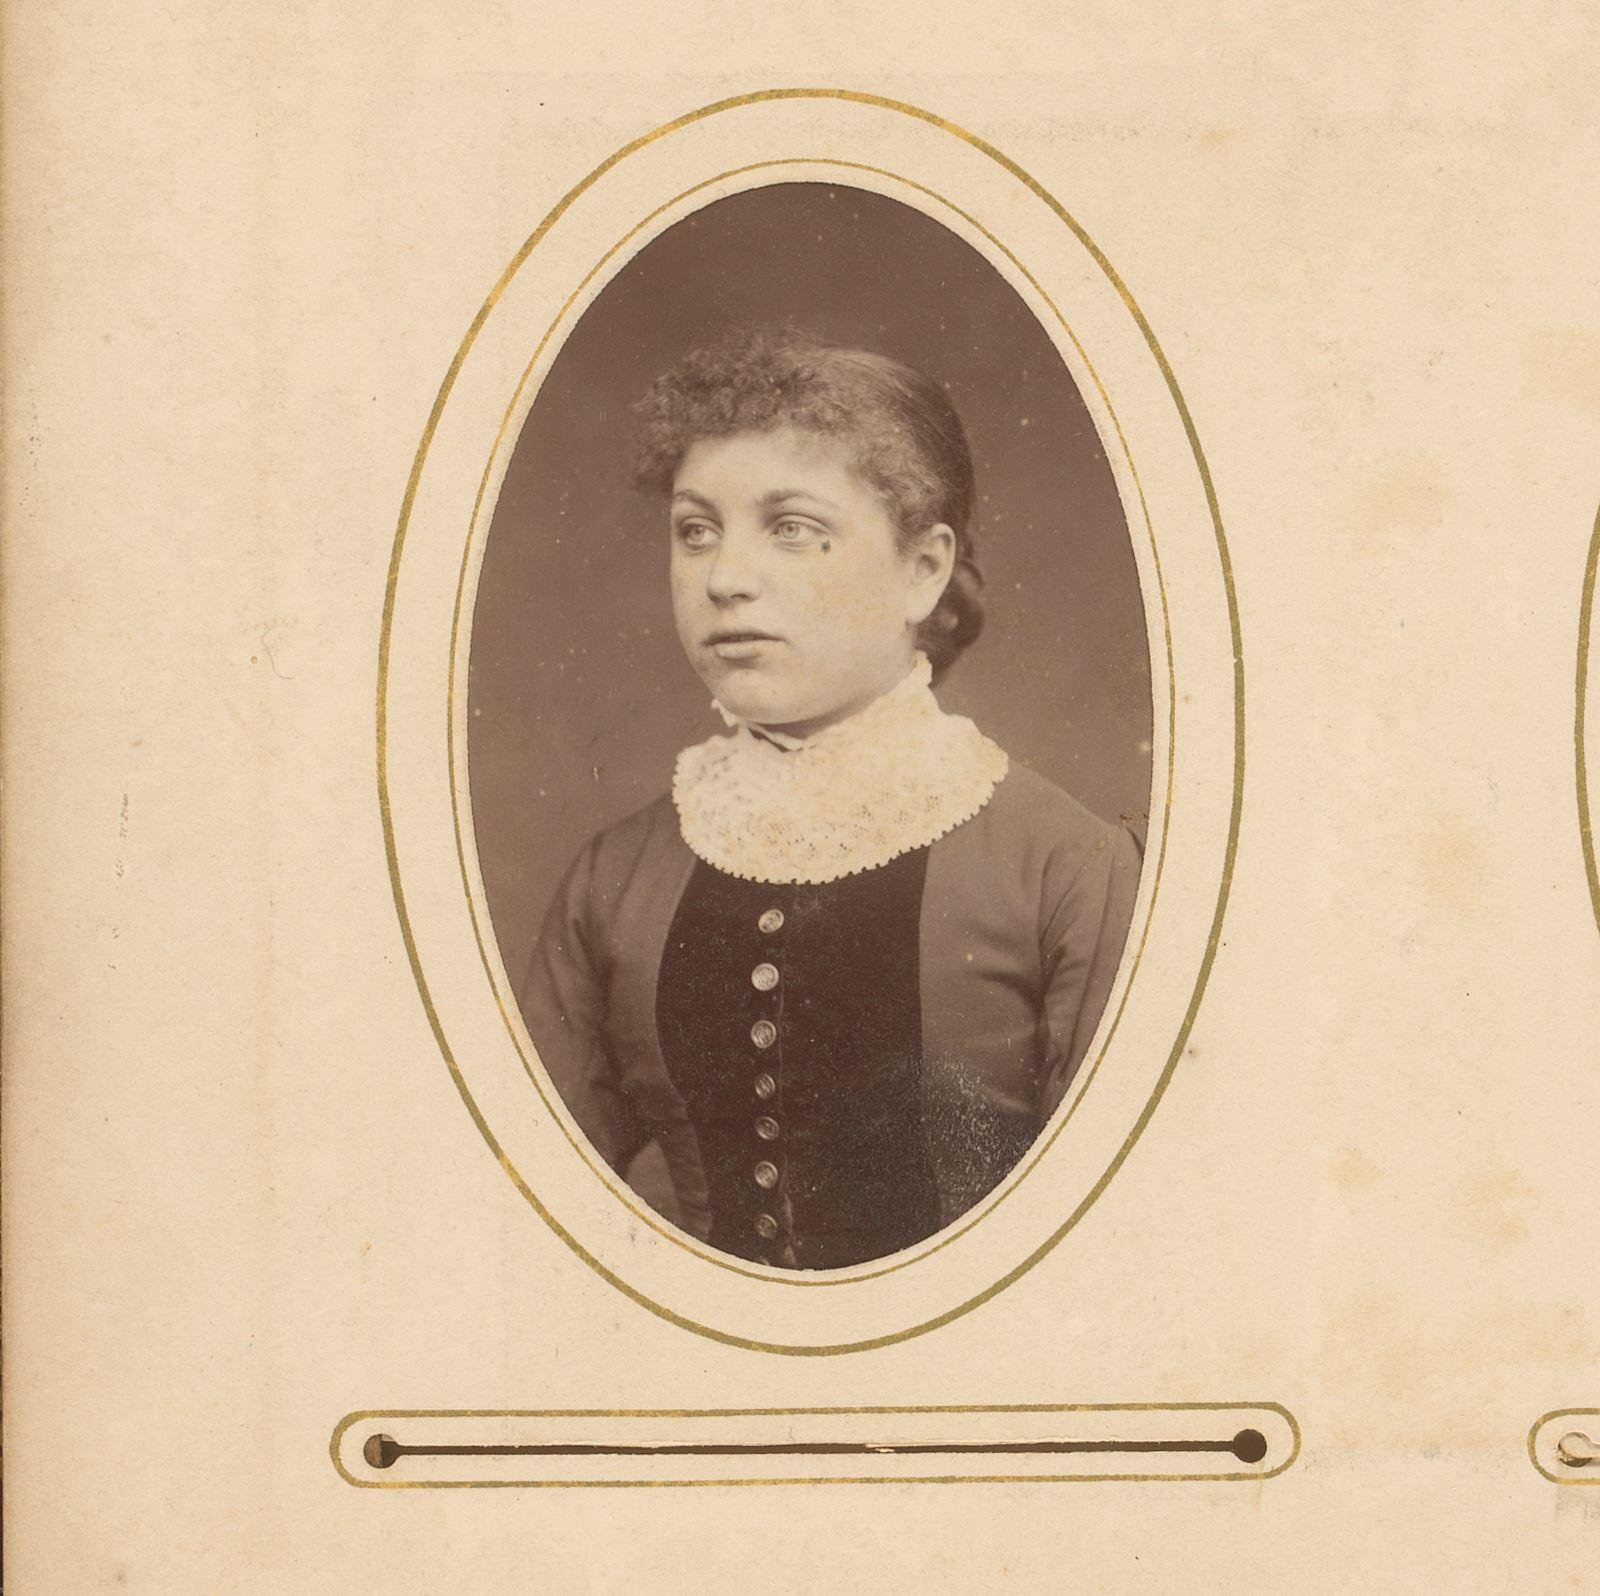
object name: album leaf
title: Portret van een jonge vrouw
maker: charles george sinclair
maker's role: fotograaf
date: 1860-1900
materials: cardboard, photographic support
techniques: albumen print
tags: adolescent, young woman, maiden, historical persons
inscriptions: inscription: ‘Picture frame manufacturer/ Chas. G. Sinclair/ Crver & Gilder/ Photographer/ & Portrait Painter/ 264, Victoria Street South/ Grimsby’